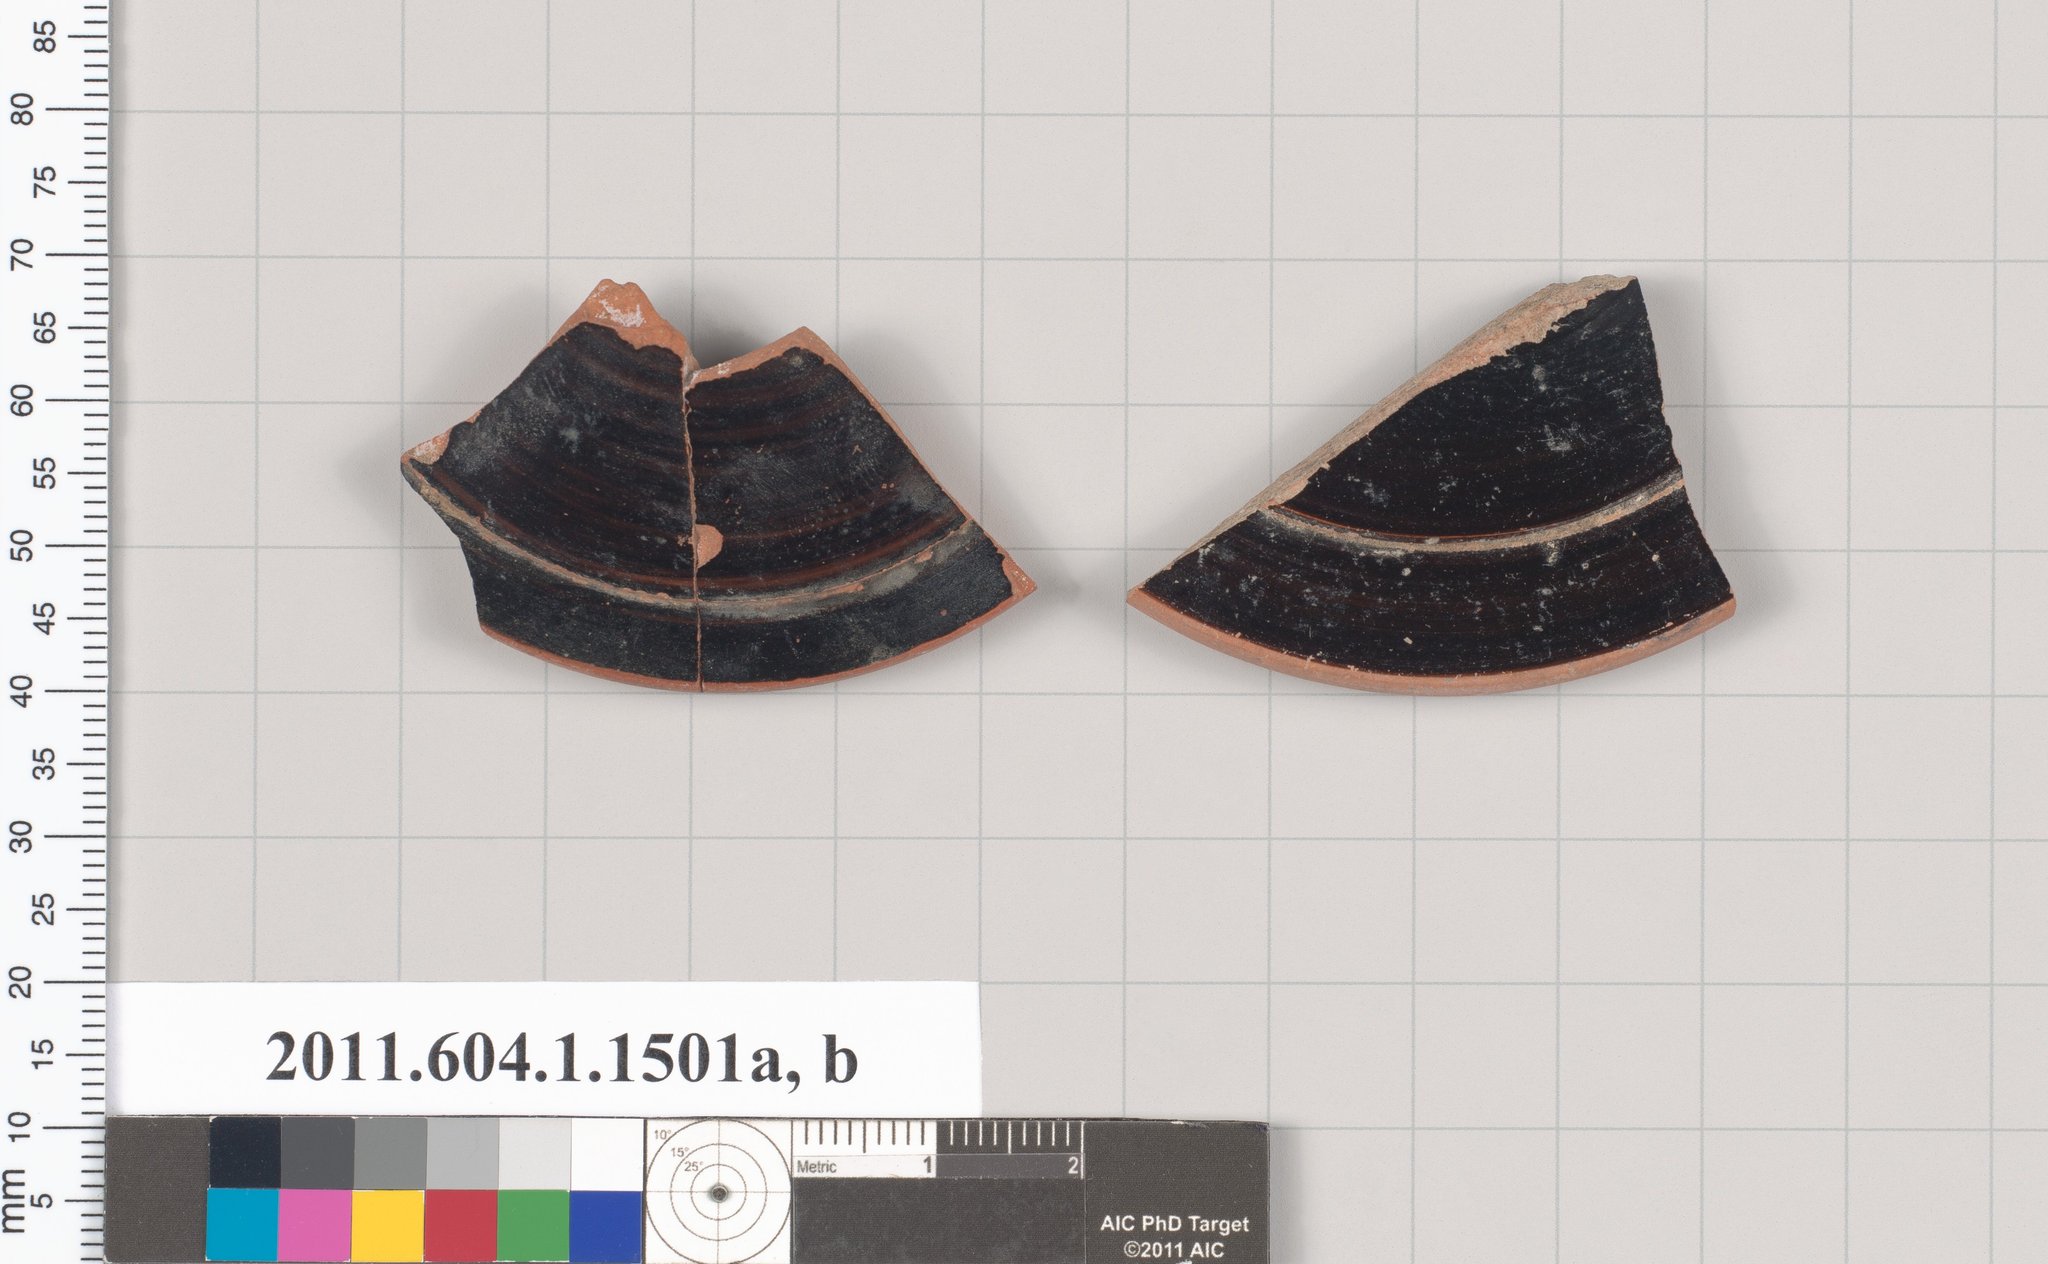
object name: kylix fragment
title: Terracotta fragments of kylikes (drinking cups)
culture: greek, attic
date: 500-401 BCE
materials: terracotta